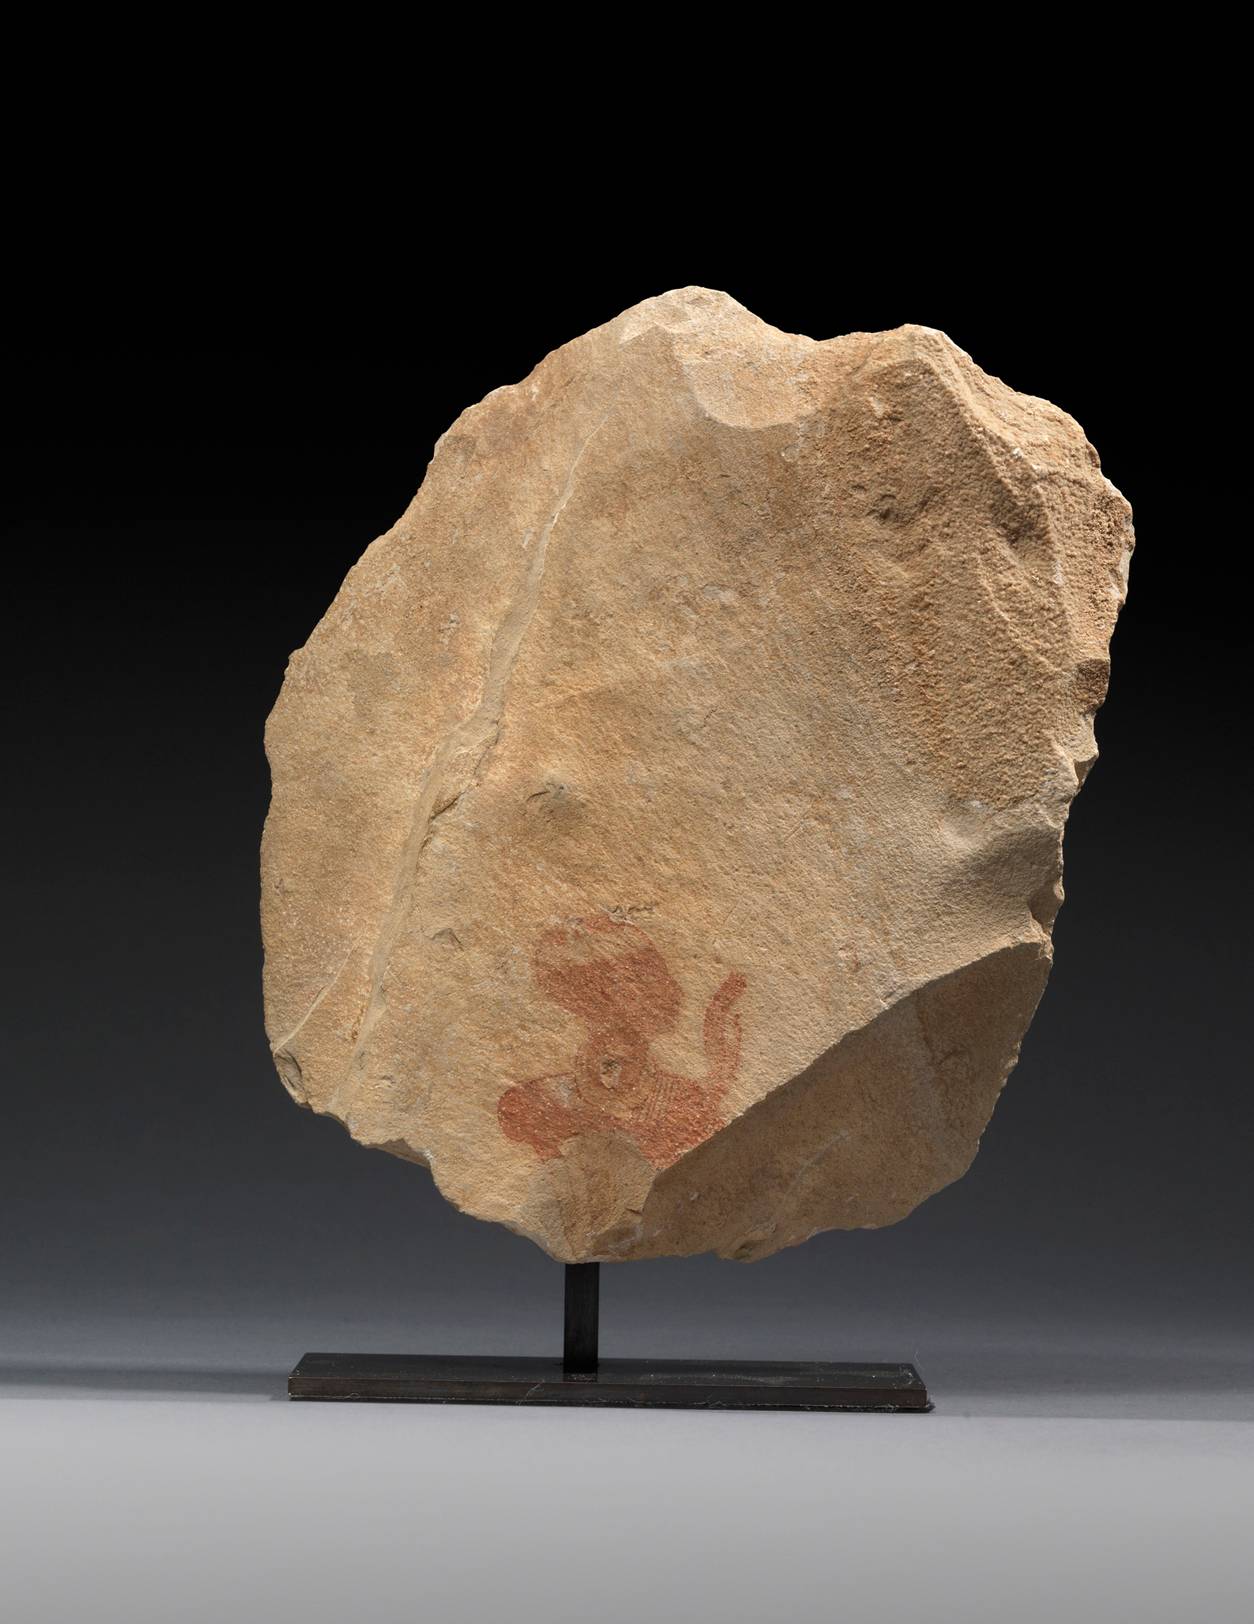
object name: ostracon, figured, priest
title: Fragmentary Ostracon Depicting a Priest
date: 1295-1070 BCE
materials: limestone, paint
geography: egypt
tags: men